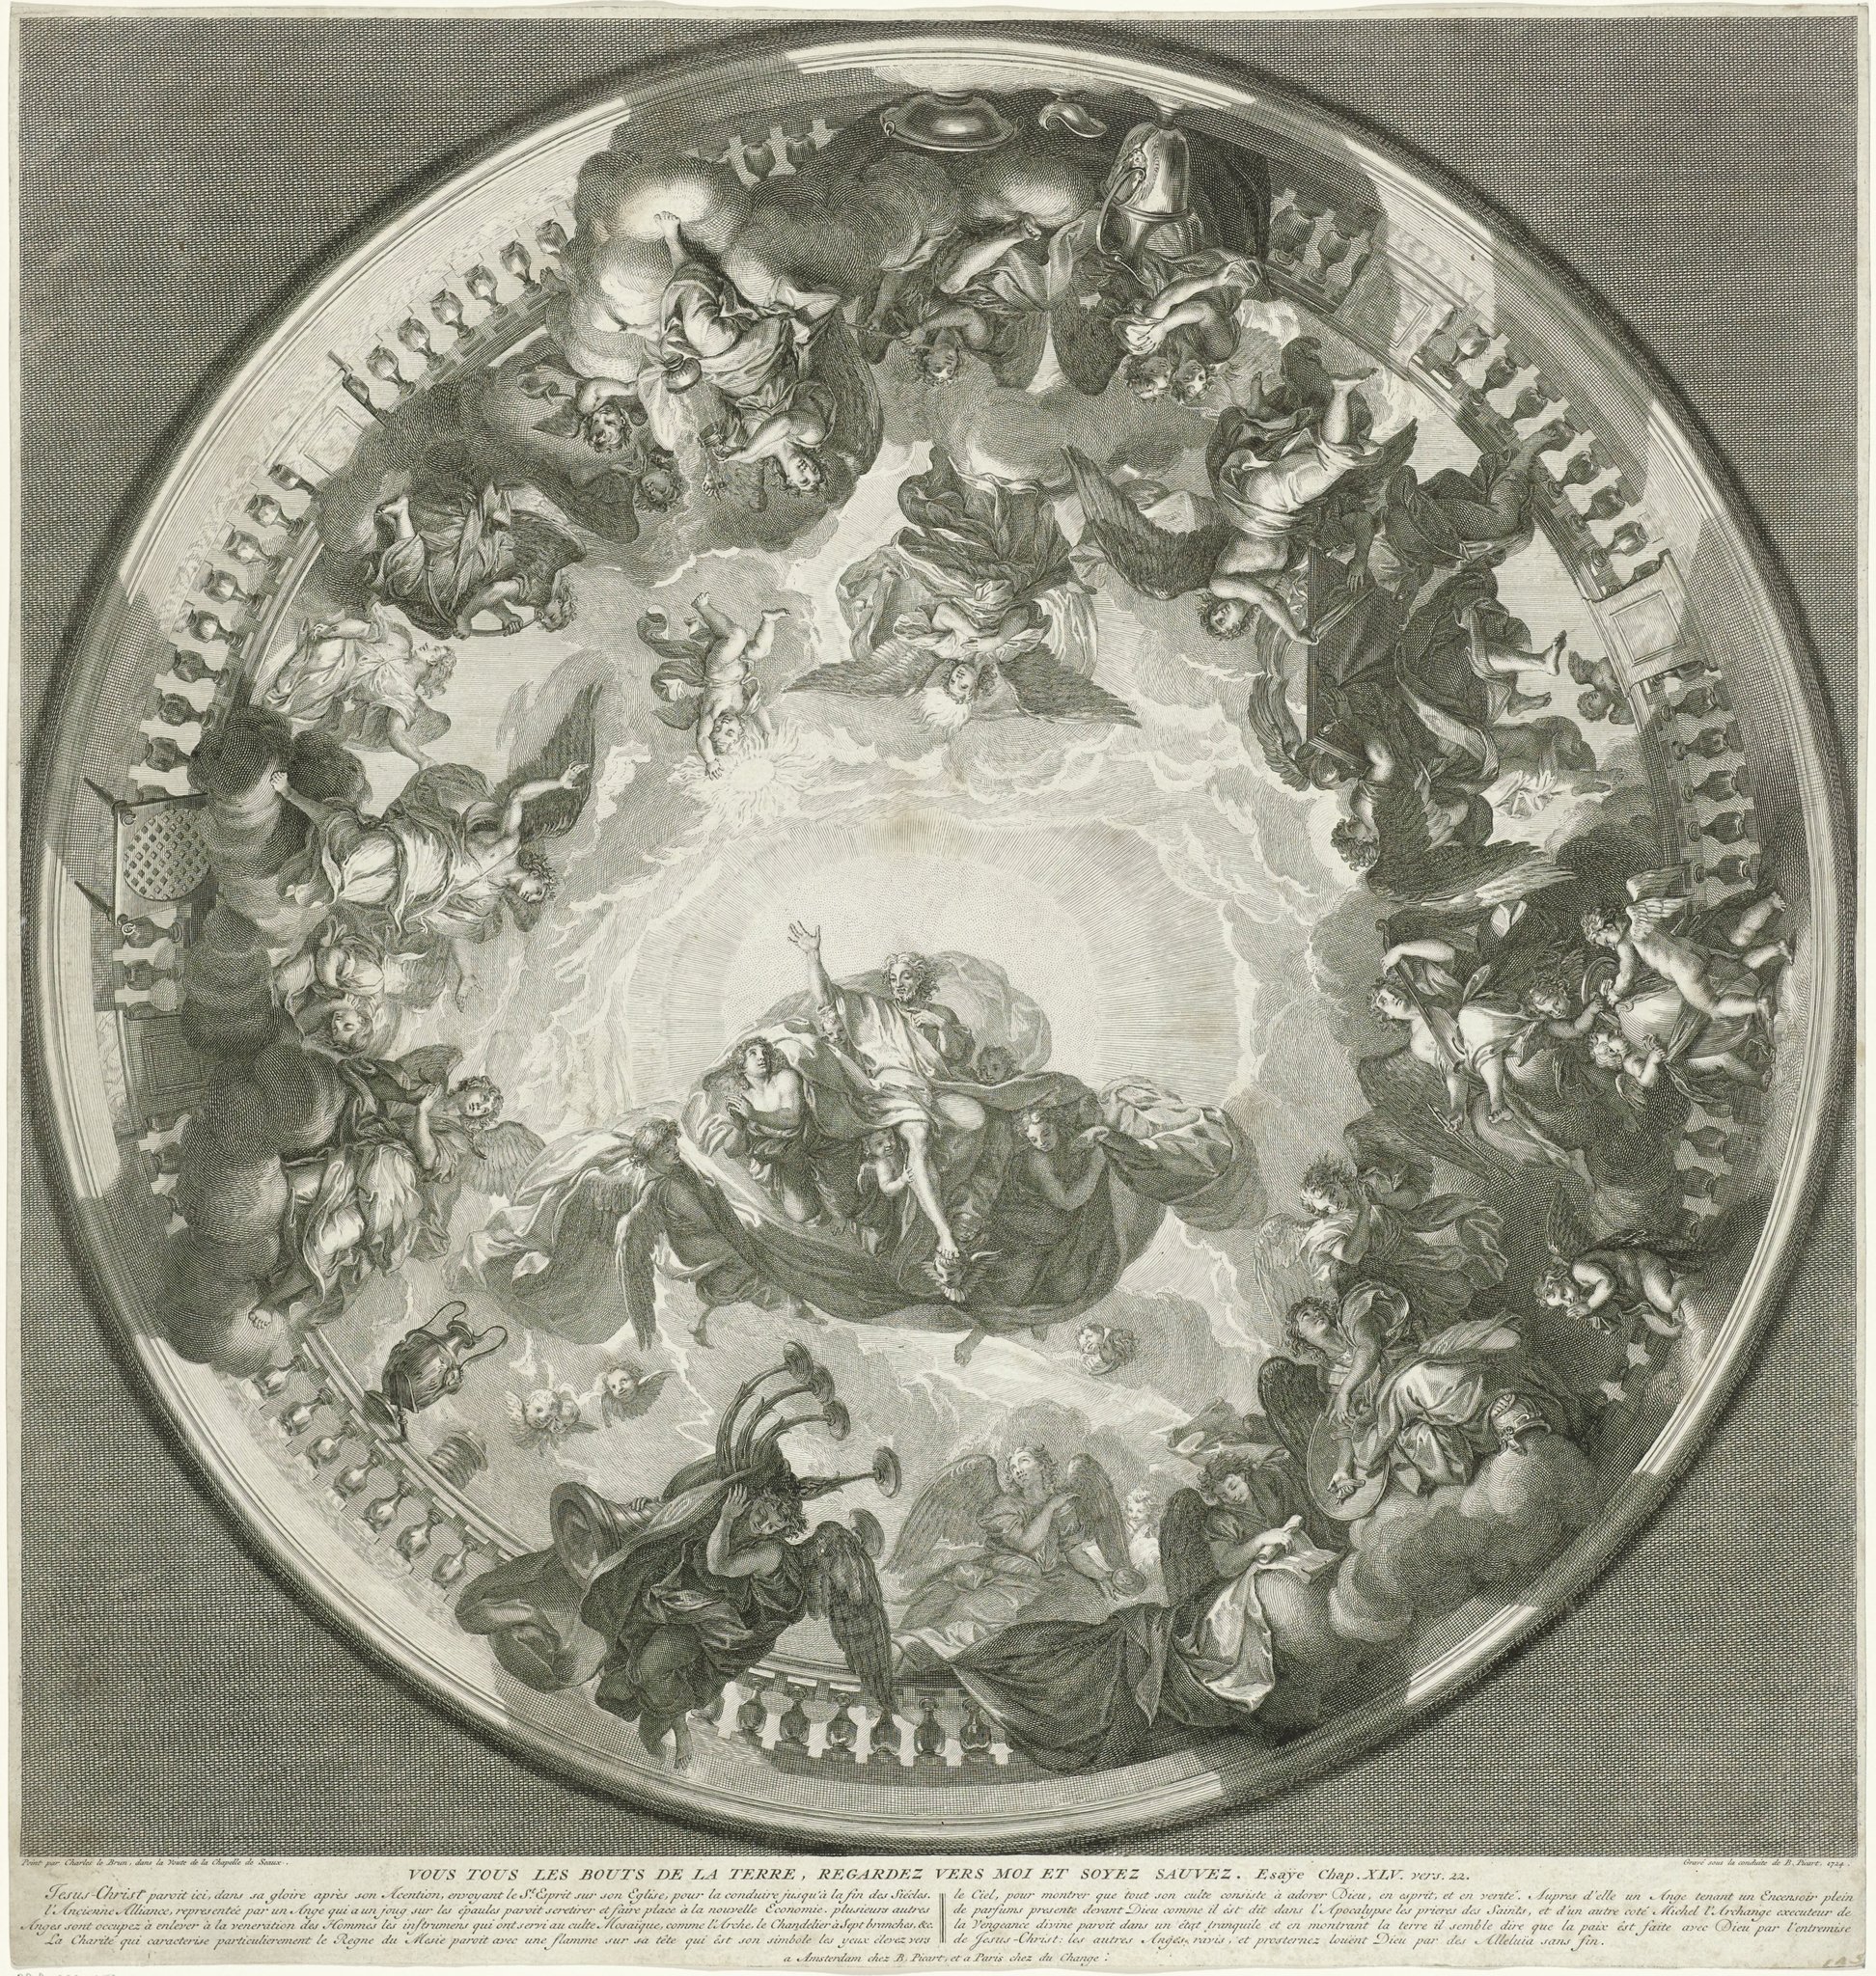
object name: print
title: Plafondschildering met Christus die de Heilige Geest naar de aarde zendt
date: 1724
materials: paper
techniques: engraving, etching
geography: amsterdam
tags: the holy ghost going out from christ, christ carried up by angels ~ ascension, (decorated) ceiling (+ variant), adult christ together with angels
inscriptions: collector's mark: Lugt 2228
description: Plafondschildering in het koepelgewelf van de Chapelle de Seaux: Christus, gedragen door engelen na zijn hemelvaart, zendt de Heilige Geest naar de aarde. Hij zit op een wolk en is omgeven, langs de rand van het ronde plafond, door talloze musicerende engelen op een balustrade. In de marge een Bijbelcitaat uit Jes. 45:22 en een toelichting op de voorstelling in het Frans.